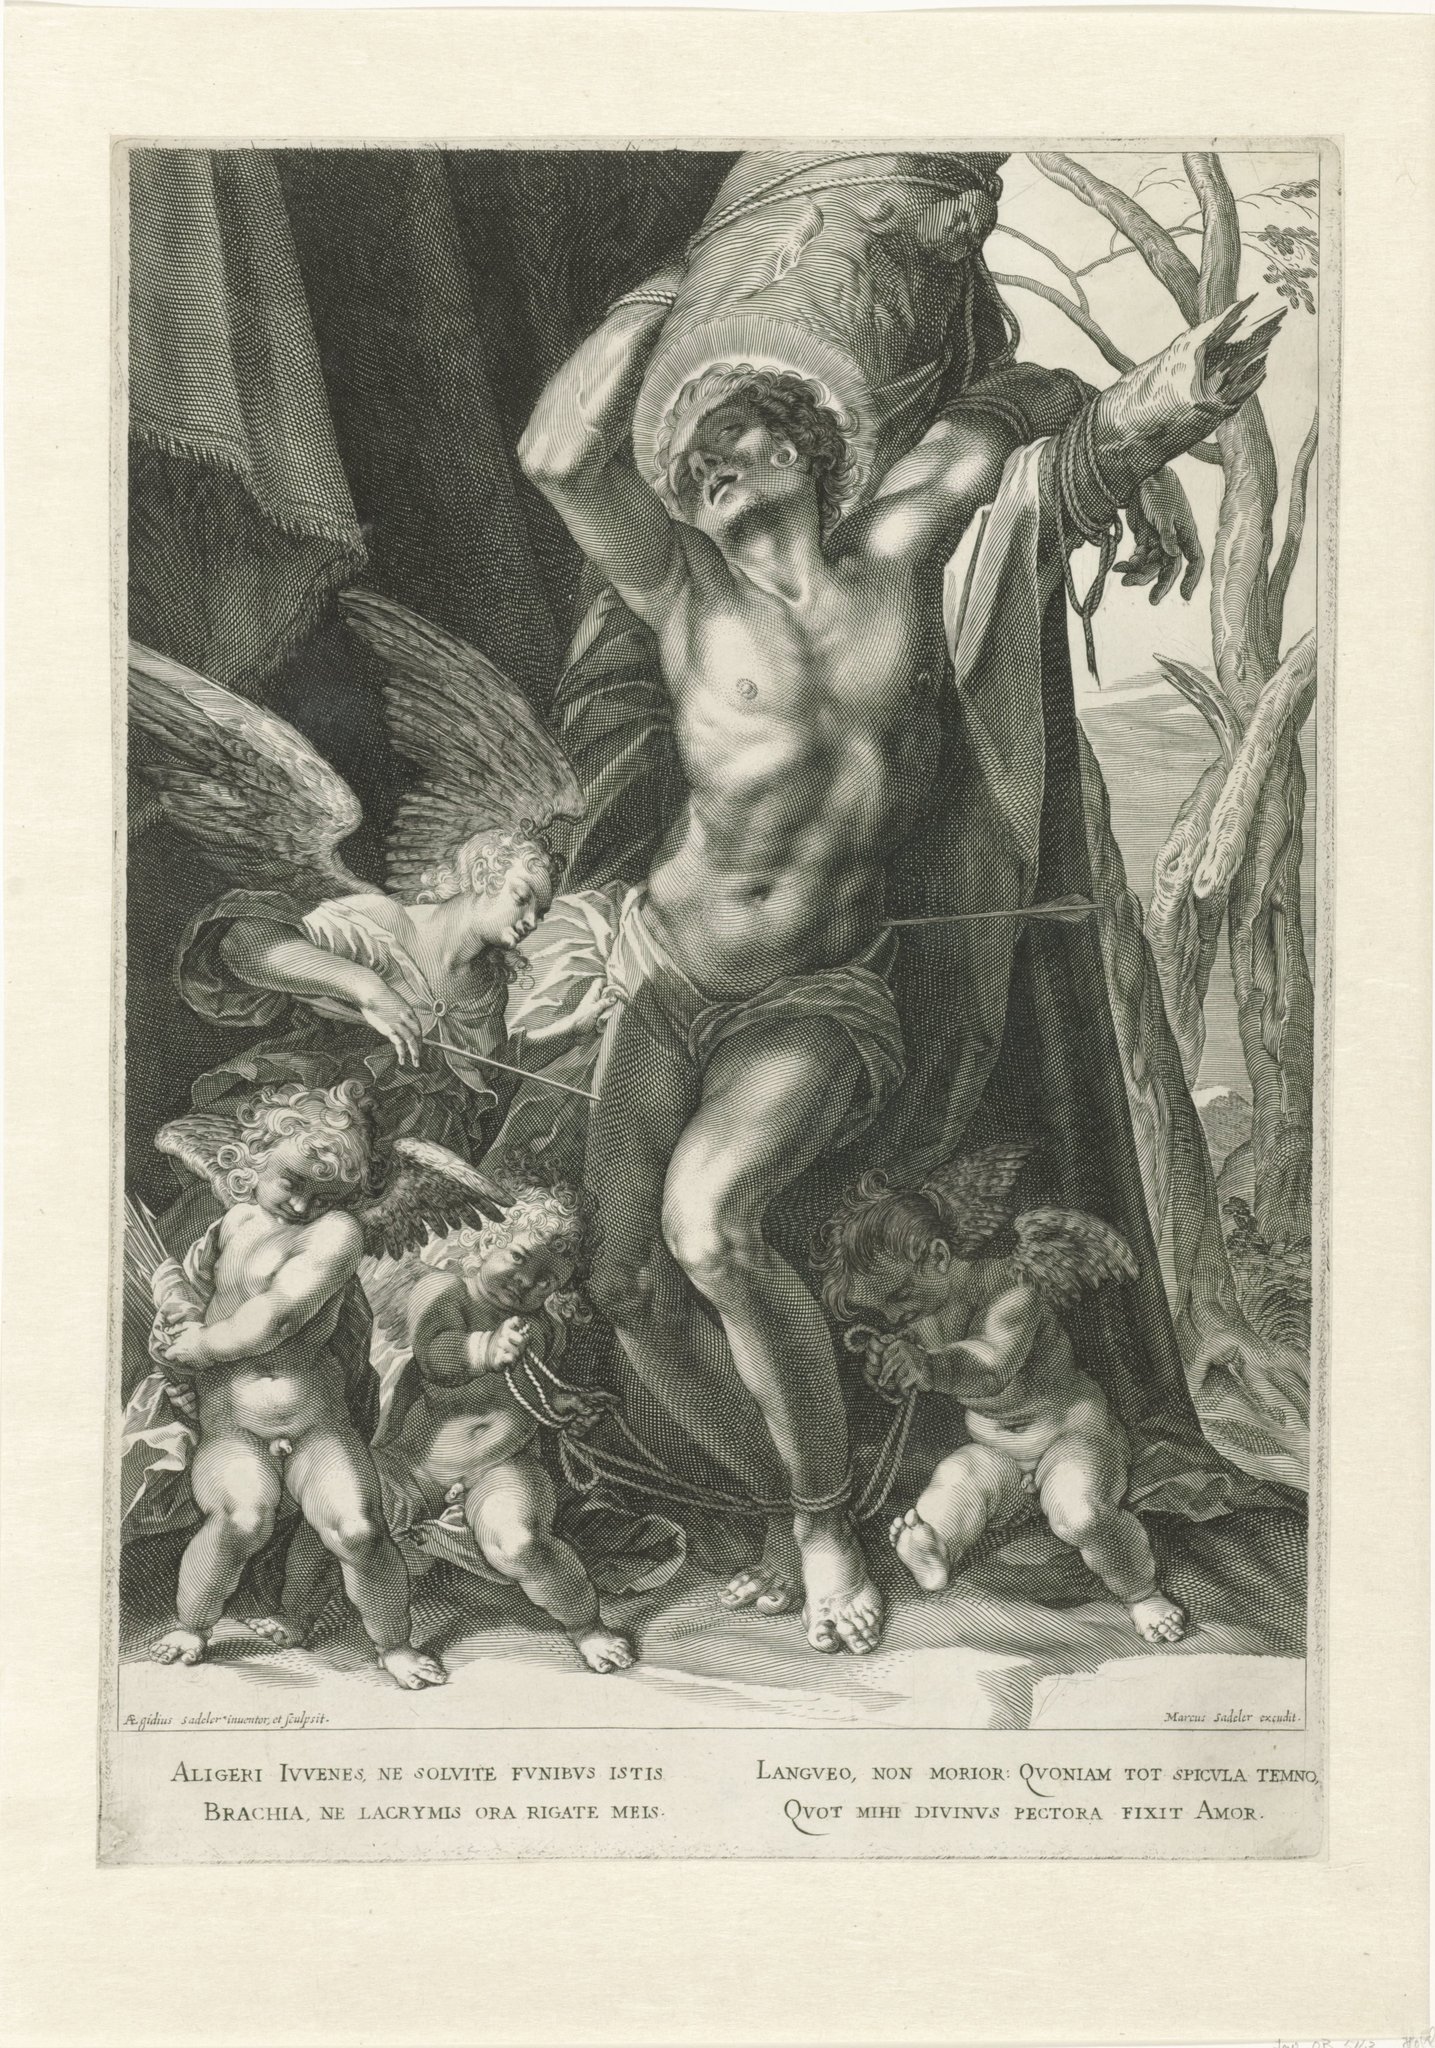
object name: print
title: Martelaarschap van de heilige Sebastiaan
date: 1580-1629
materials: paper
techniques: engraving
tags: st. sebastian succoured by angels, who untie him from the tree or pillar and remove the arrows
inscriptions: collector's mark: Lugt 240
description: De H. Sebastiaan, vastgebonden aan een boom. Hij heeft een pijl in zijn zijde. Een andere pijl in wordt door een engel uit zijn been getrokken. Putti maken de touwen om zijn benen los.